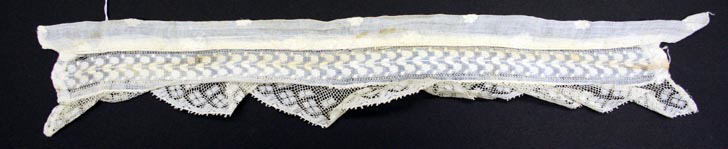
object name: collar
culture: american or european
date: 1700-1945